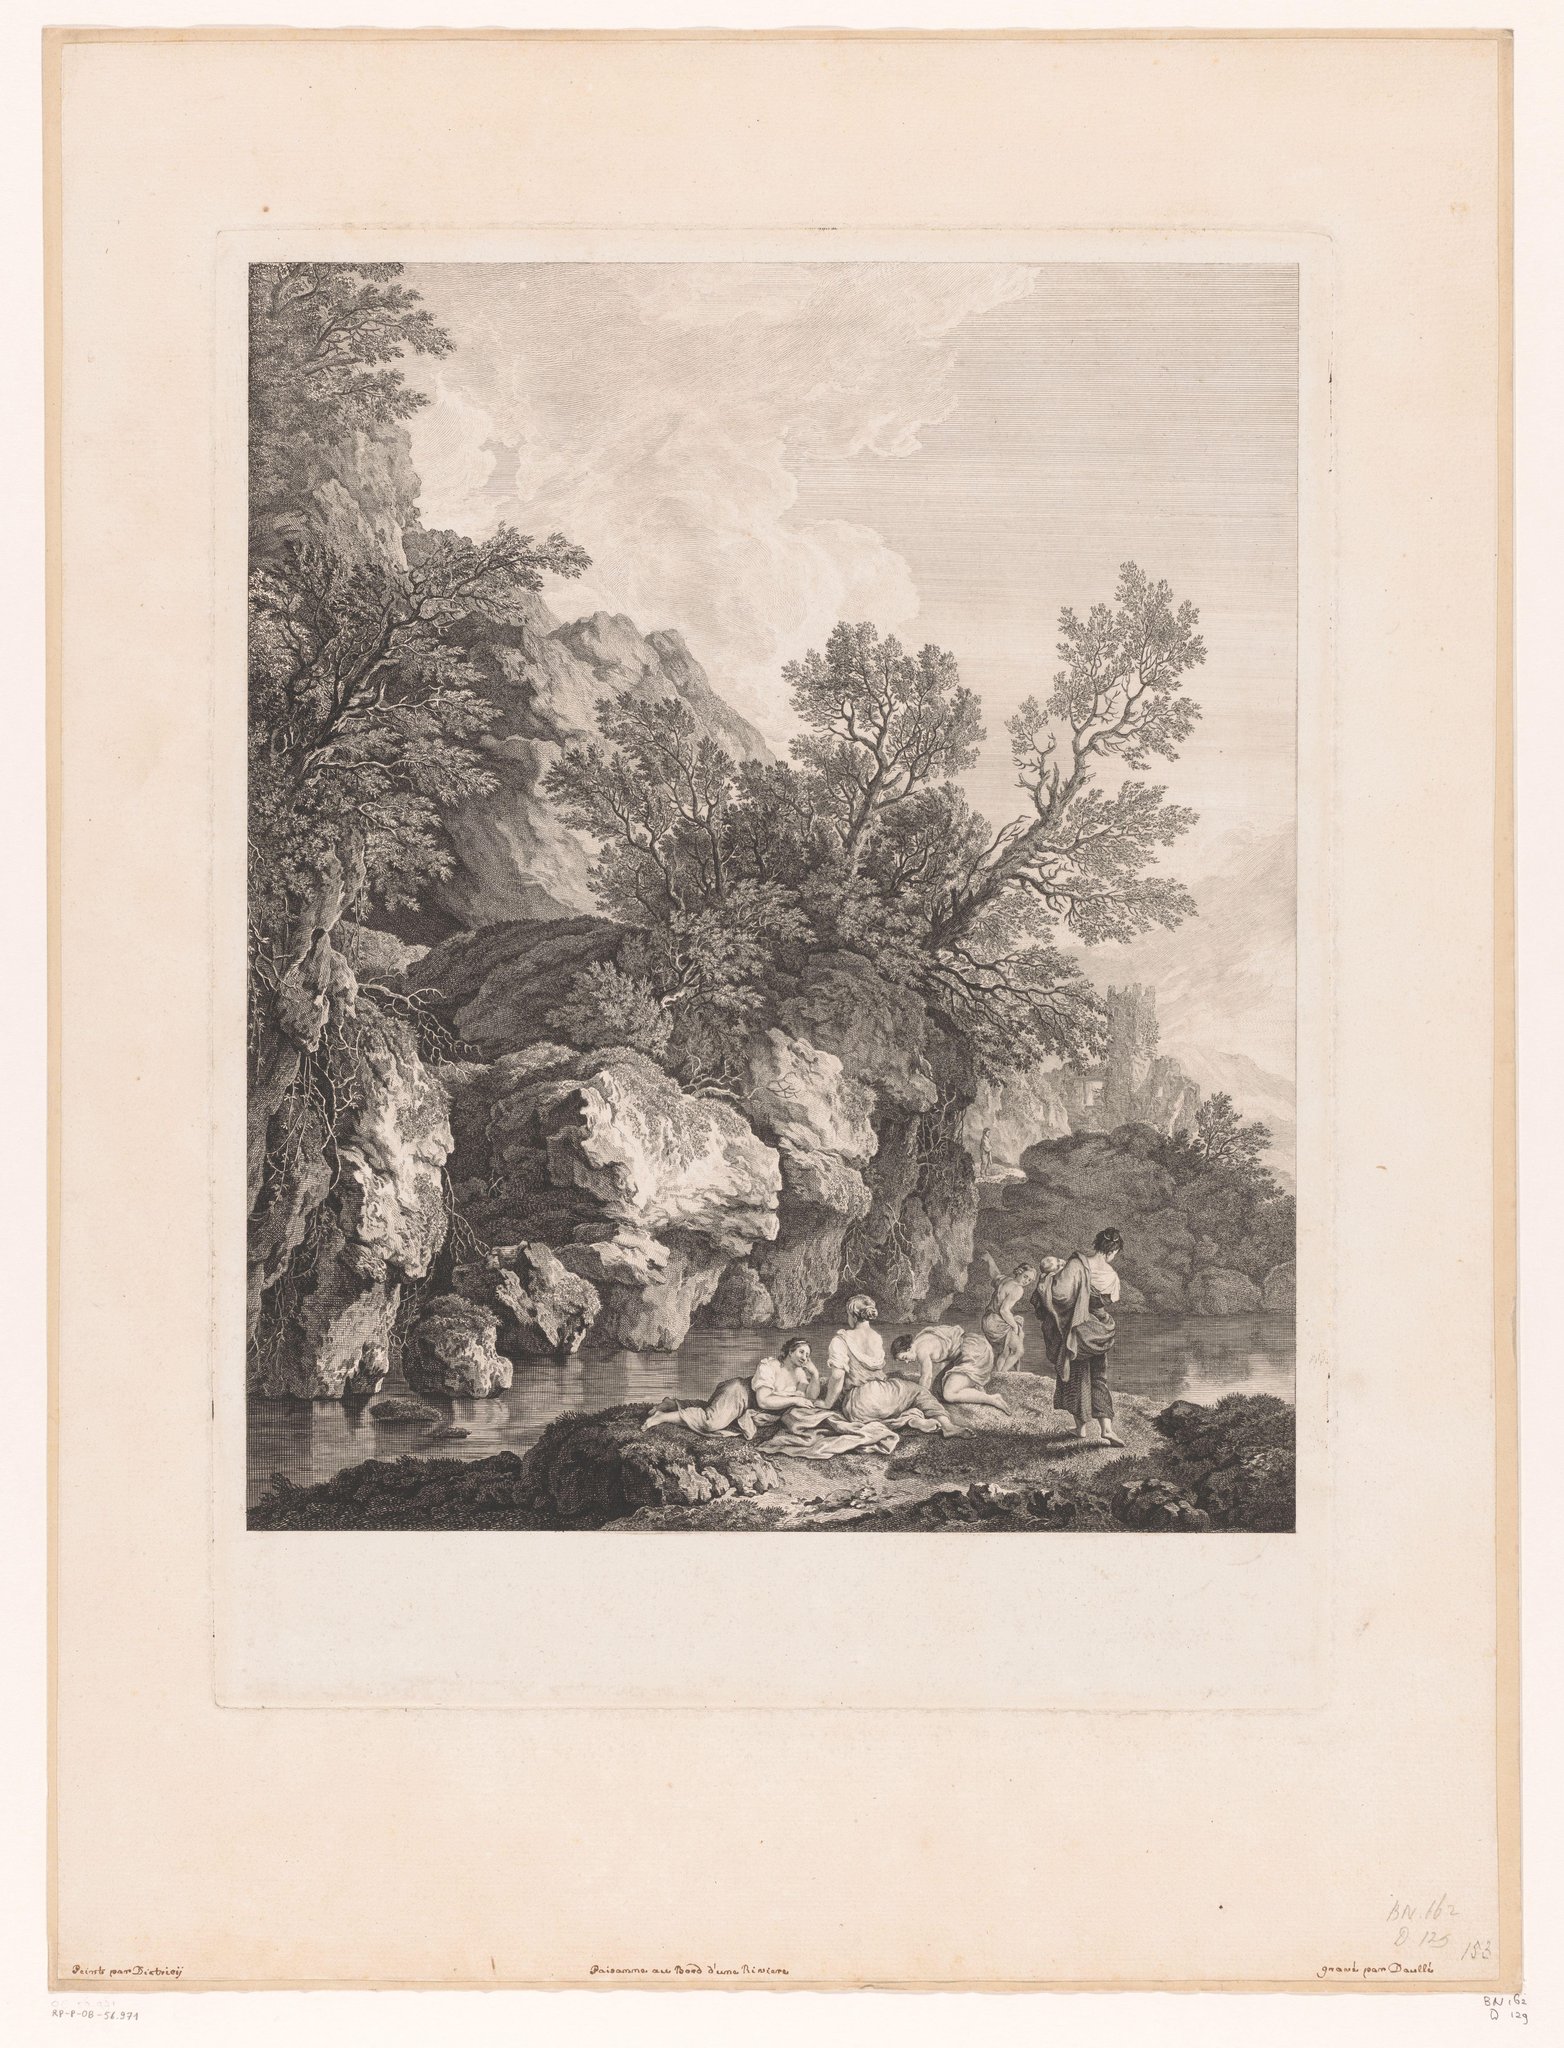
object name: print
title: Badende vrouwen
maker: jean daullé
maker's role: print maker, publisher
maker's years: 1703-1763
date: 1761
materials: paper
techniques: engraving, etching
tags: taking a bath - aa - in the open air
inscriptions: collector's mark: Lugt 240